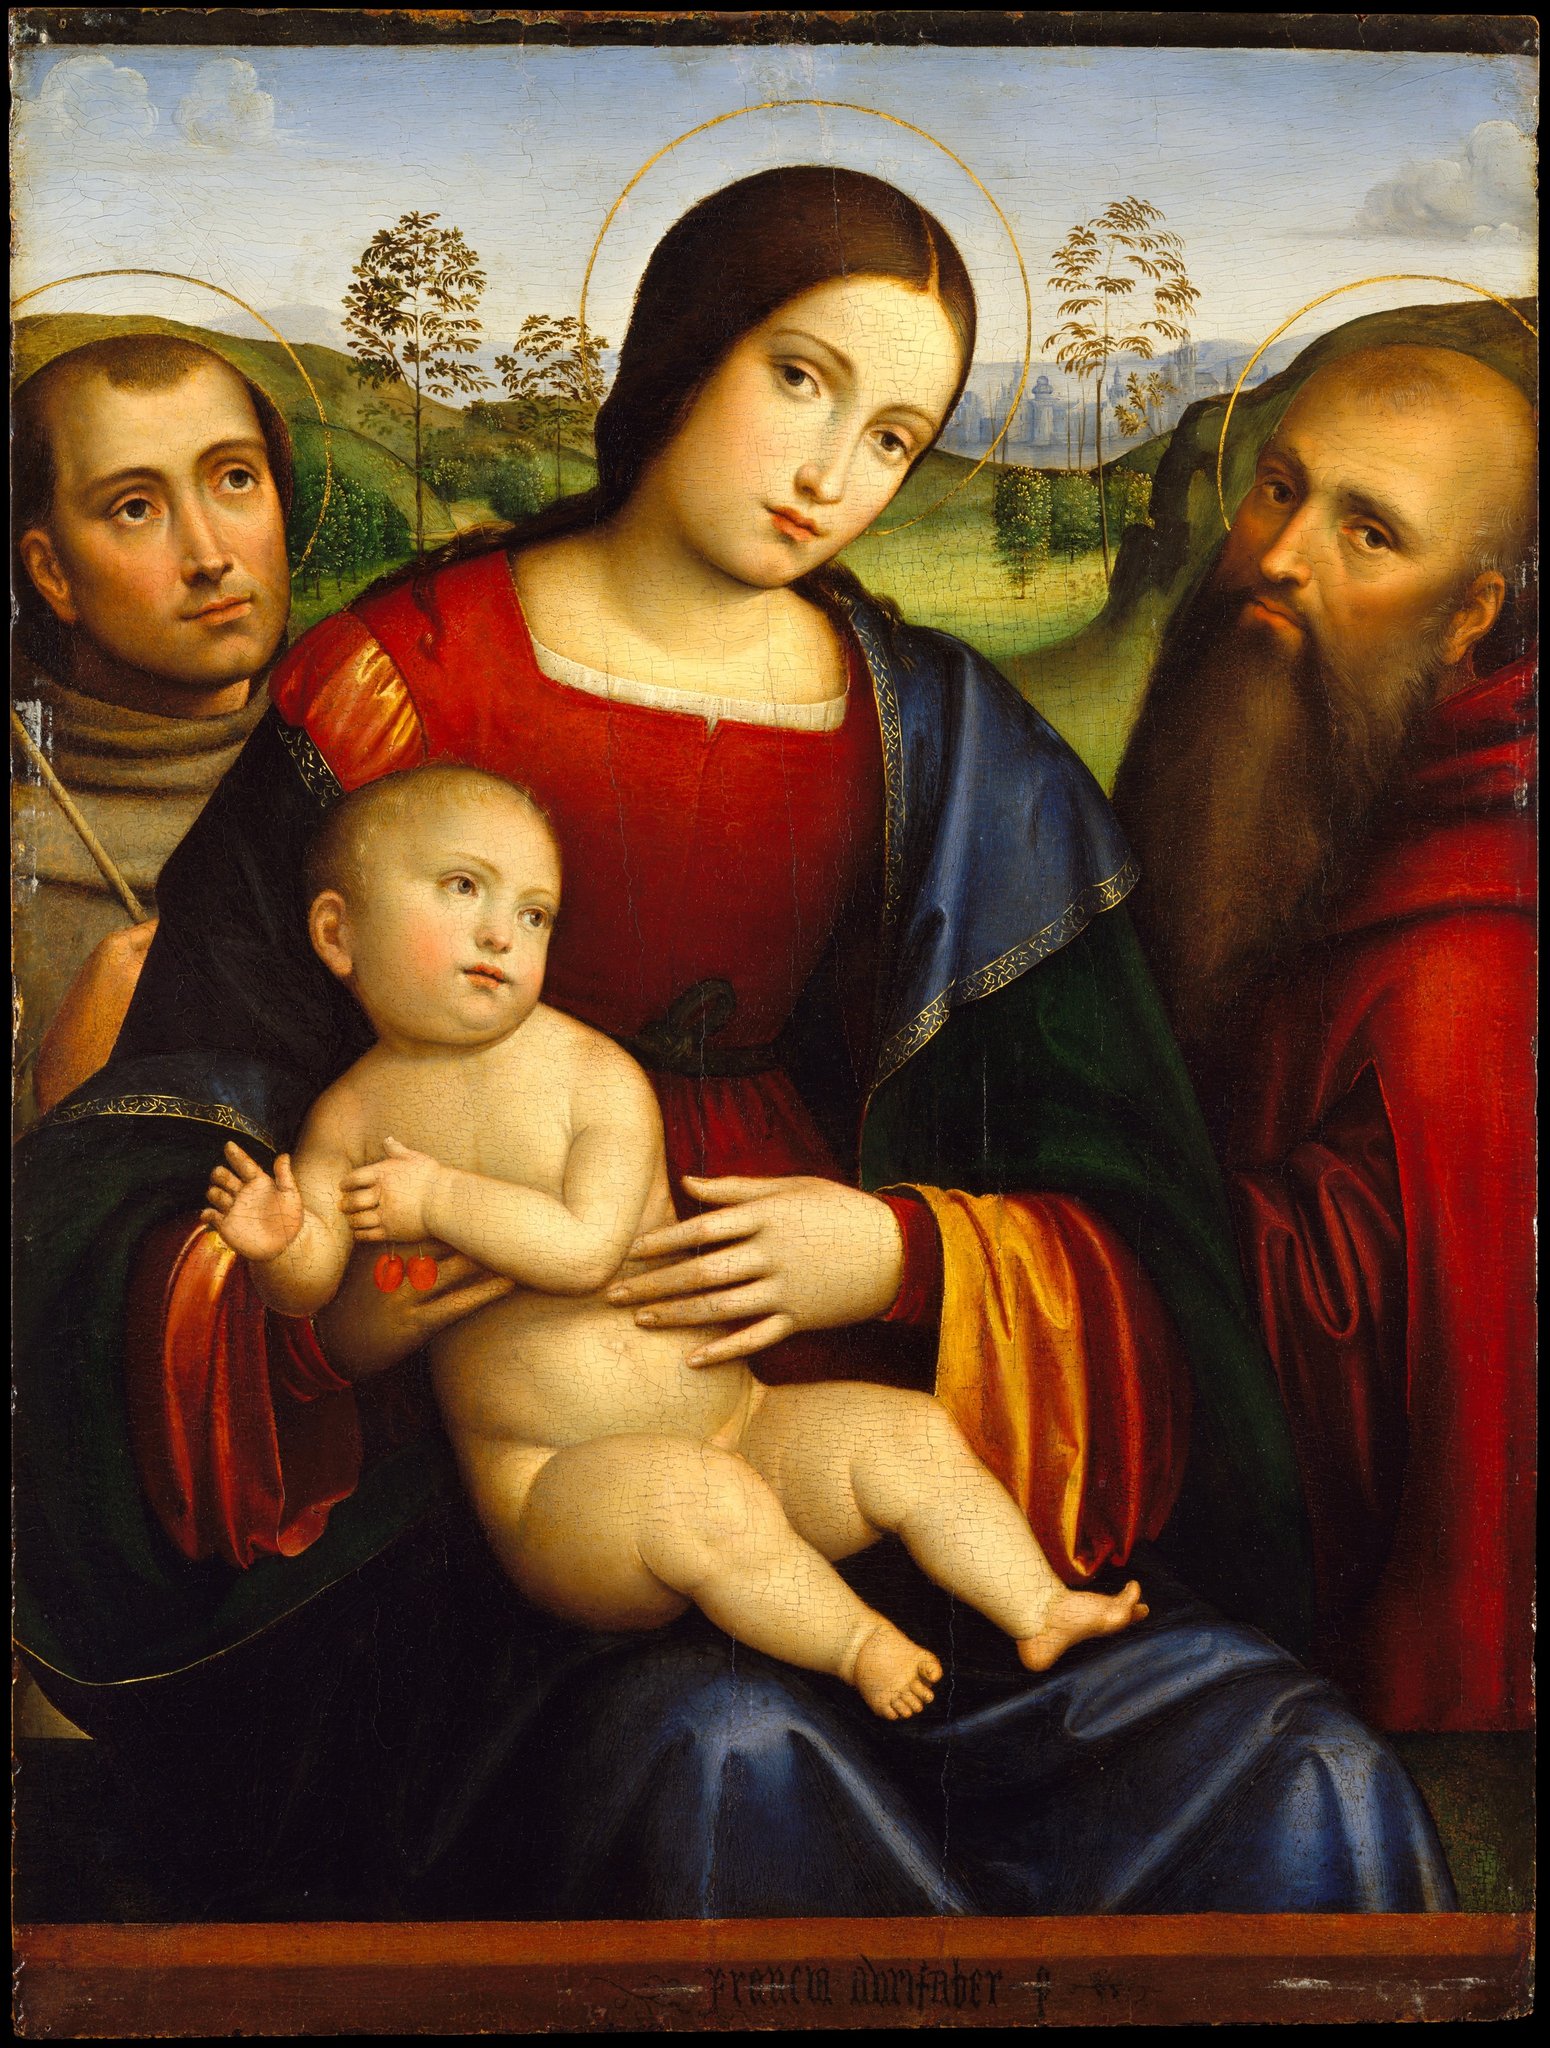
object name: painting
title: Madonna and Child with Saints Francis and Jerome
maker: francesco francia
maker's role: artist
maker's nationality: italian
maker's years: 1447-1517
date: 1512-1515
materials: gold, oil, wood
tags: christ,madonna and child,saint francis,saint jerome,virgin mary